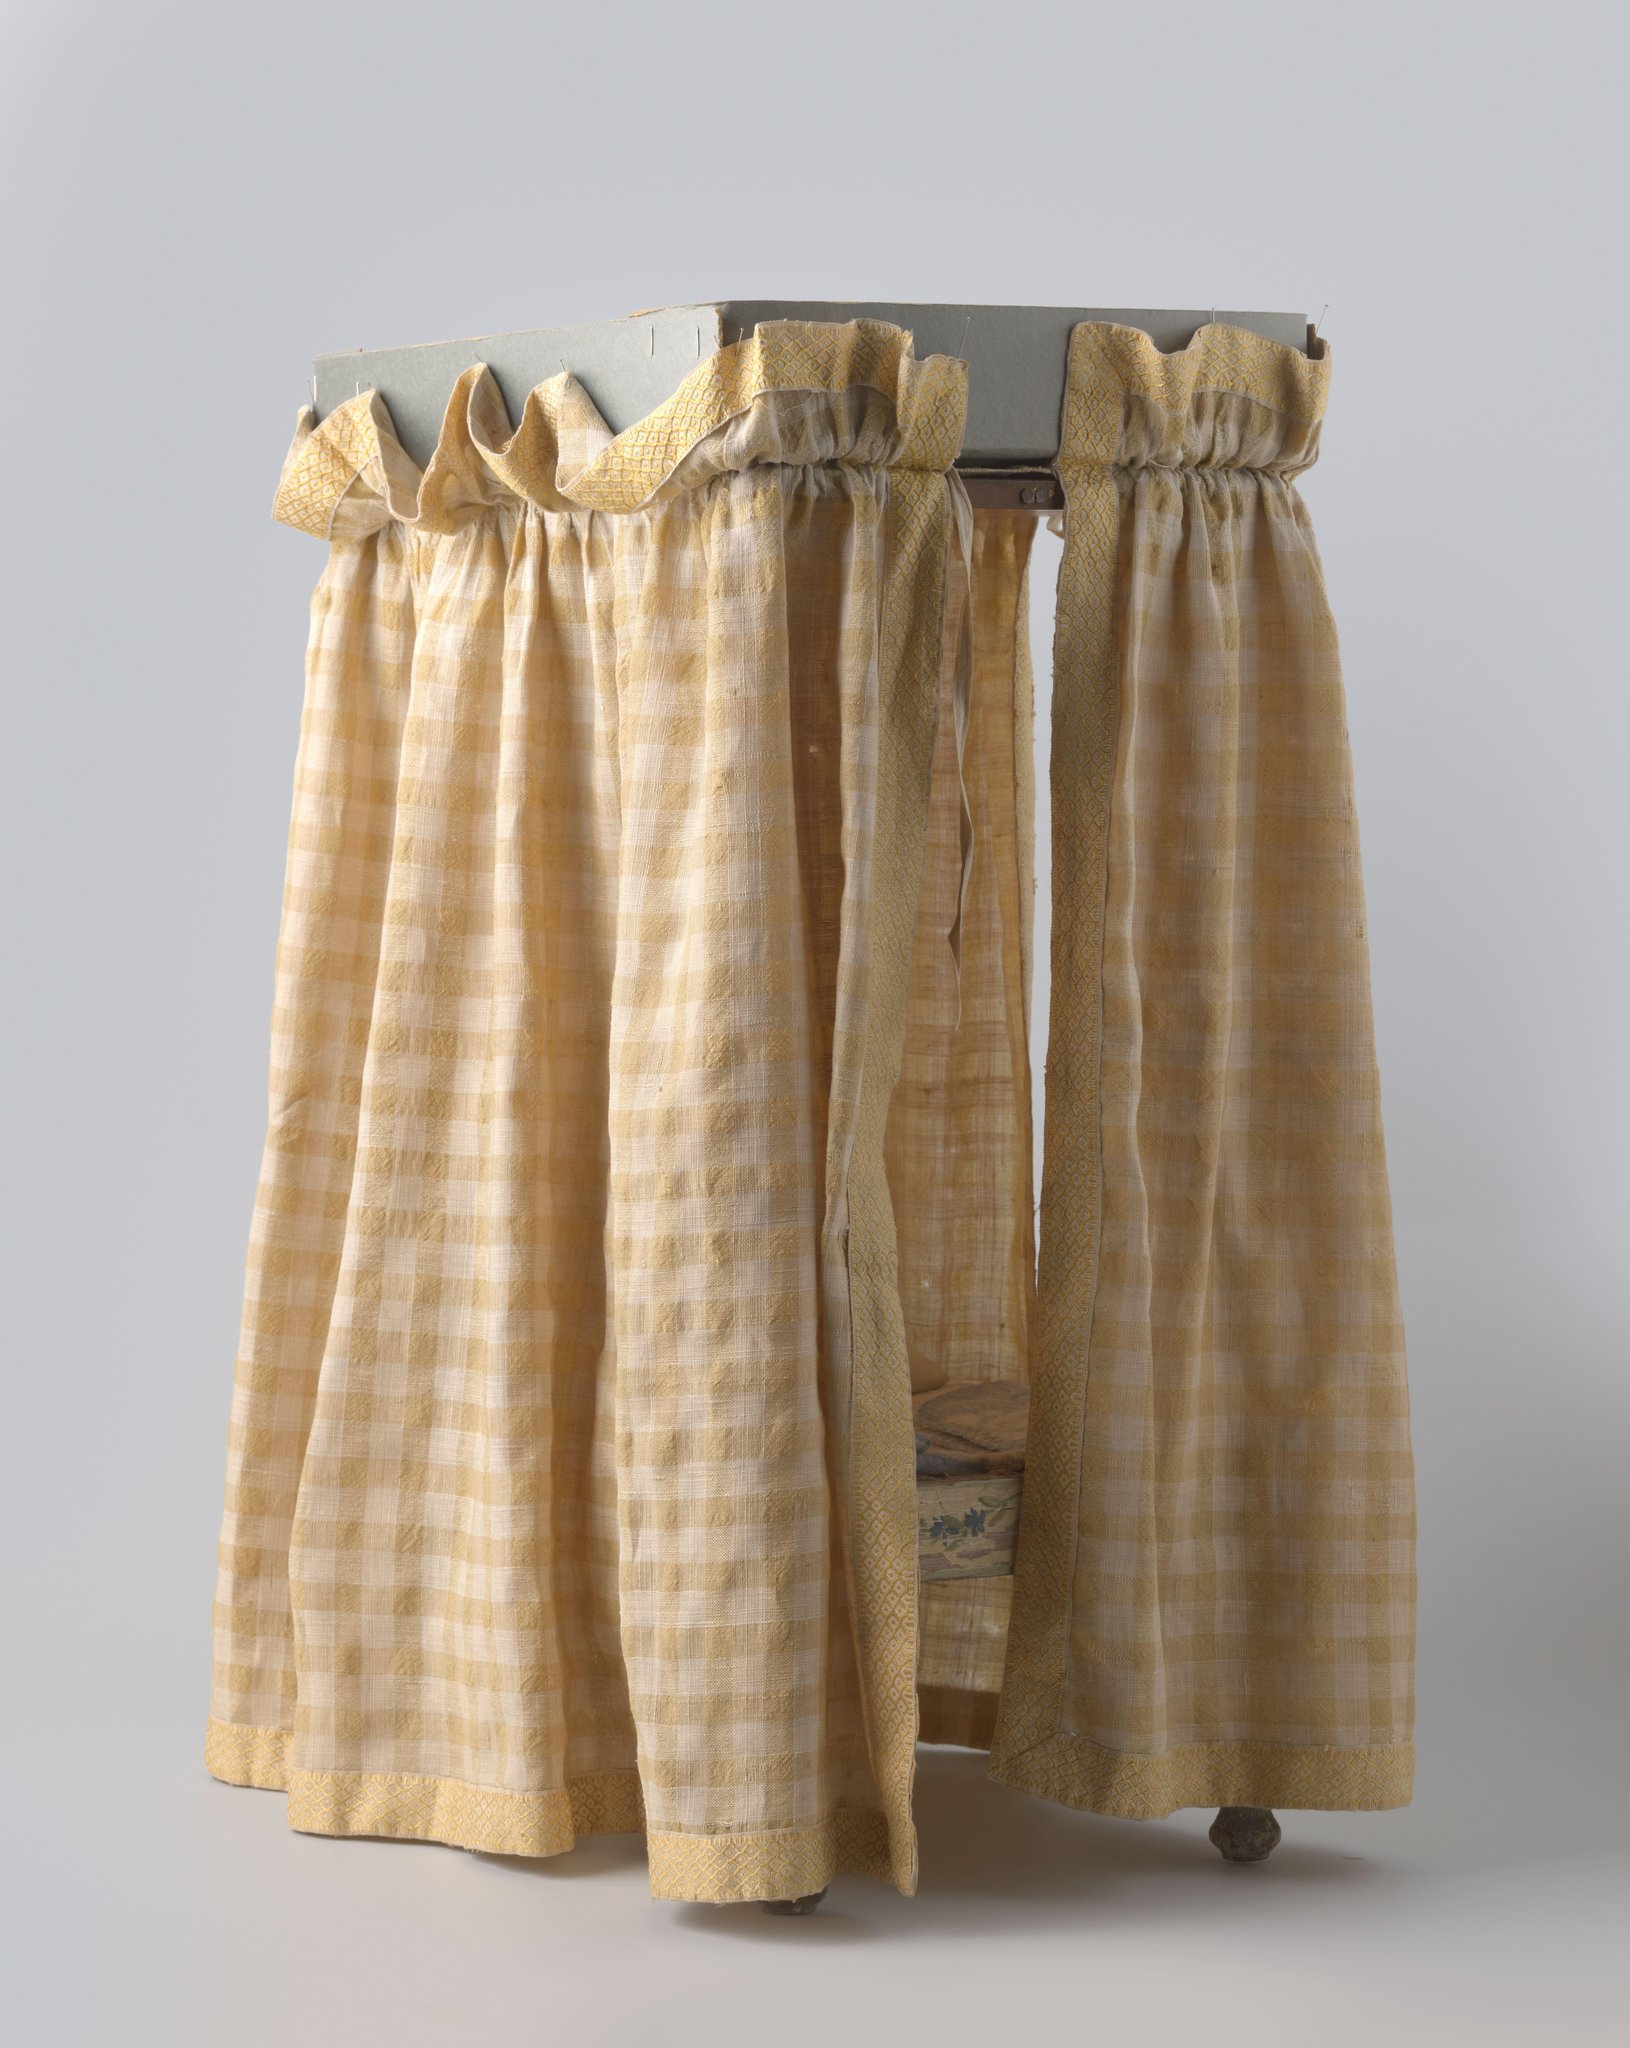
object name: canopy bed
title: Poppenhemelbed met bloemslingers op witte fond. Behangen met geruite gordijnen. Met inhoud.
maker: Anonymous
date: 1600-1699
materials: textile, linen, wood, silk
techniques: napping, painted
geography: northern netherlands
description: Poppenhemelbed van eikenhout, op een wit fond beschilderd met bloemslingers en groene biezen, behangen met geel geruite gordijnen. De balusterpoten dragen huizen en geleding. Het hoofdeinde is accoladevormig geschulpt. De regels zijn betimmerd met groen-wit gestreepte singelbanden. De hemel rust op vier ronde hoekstijlen ("fourposter"). Textilia: een groot en een klein kussen, drie slopen (wit, rood geruit, blauw-wit gestreept) en een deken (aan de bovenkant met een blauw/roze/wit gestreept bloemenmotief).